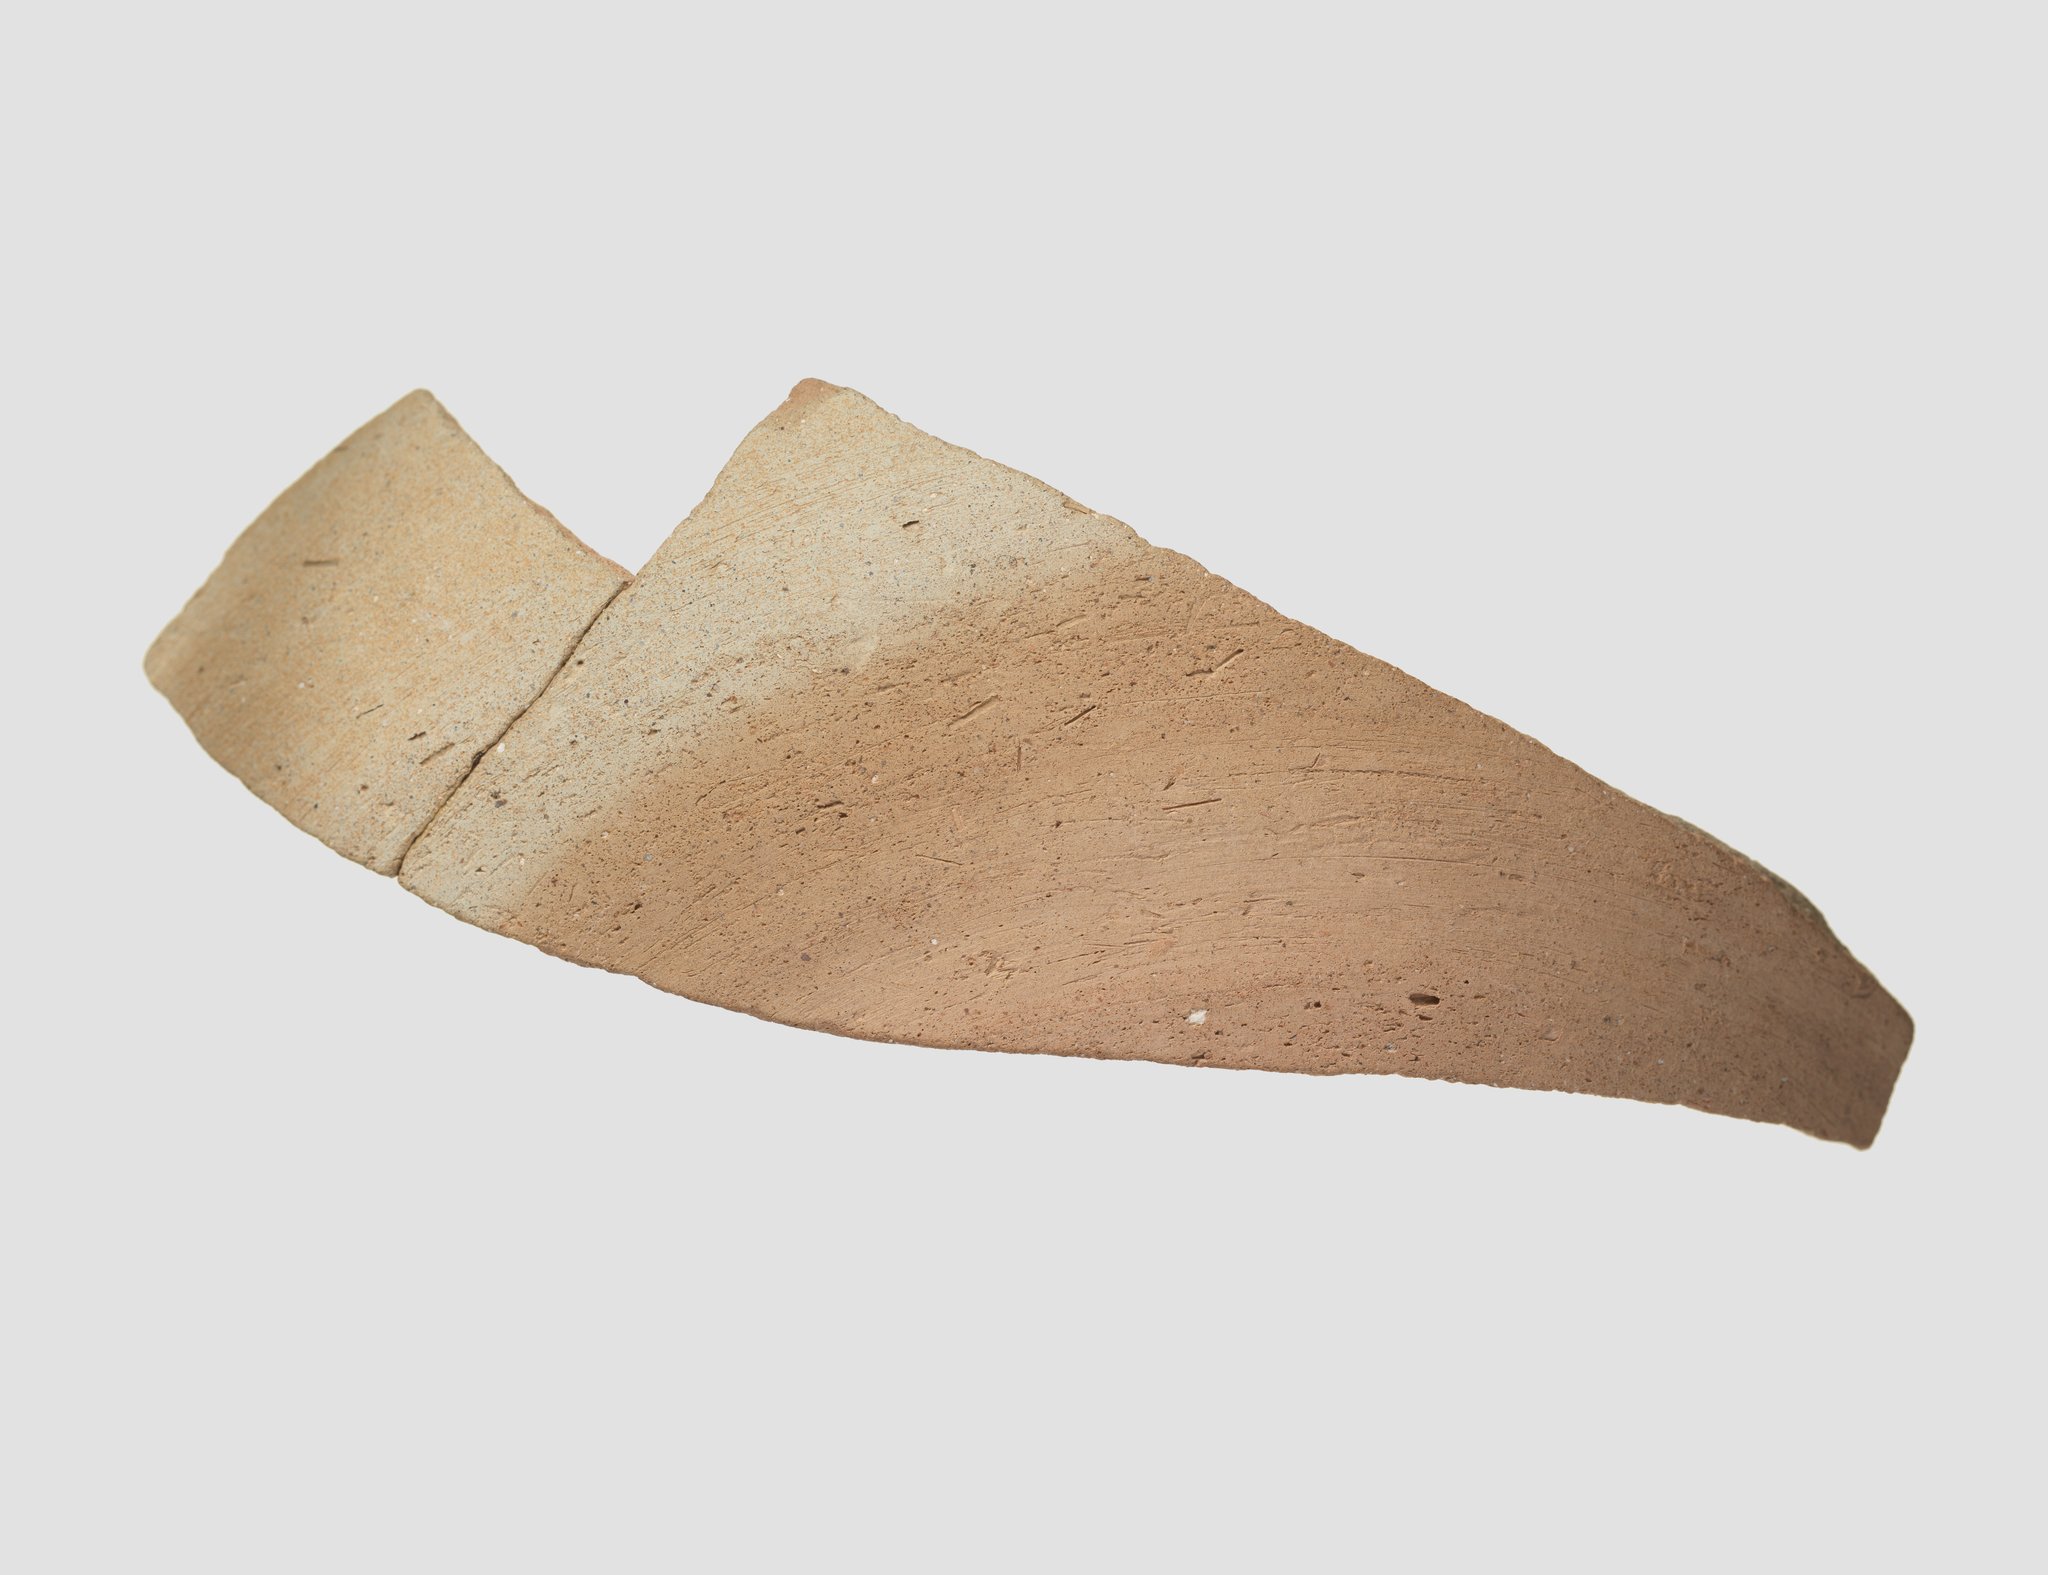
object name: sherd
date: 2333-2001 BCE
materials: ceramic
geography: mesopotamia